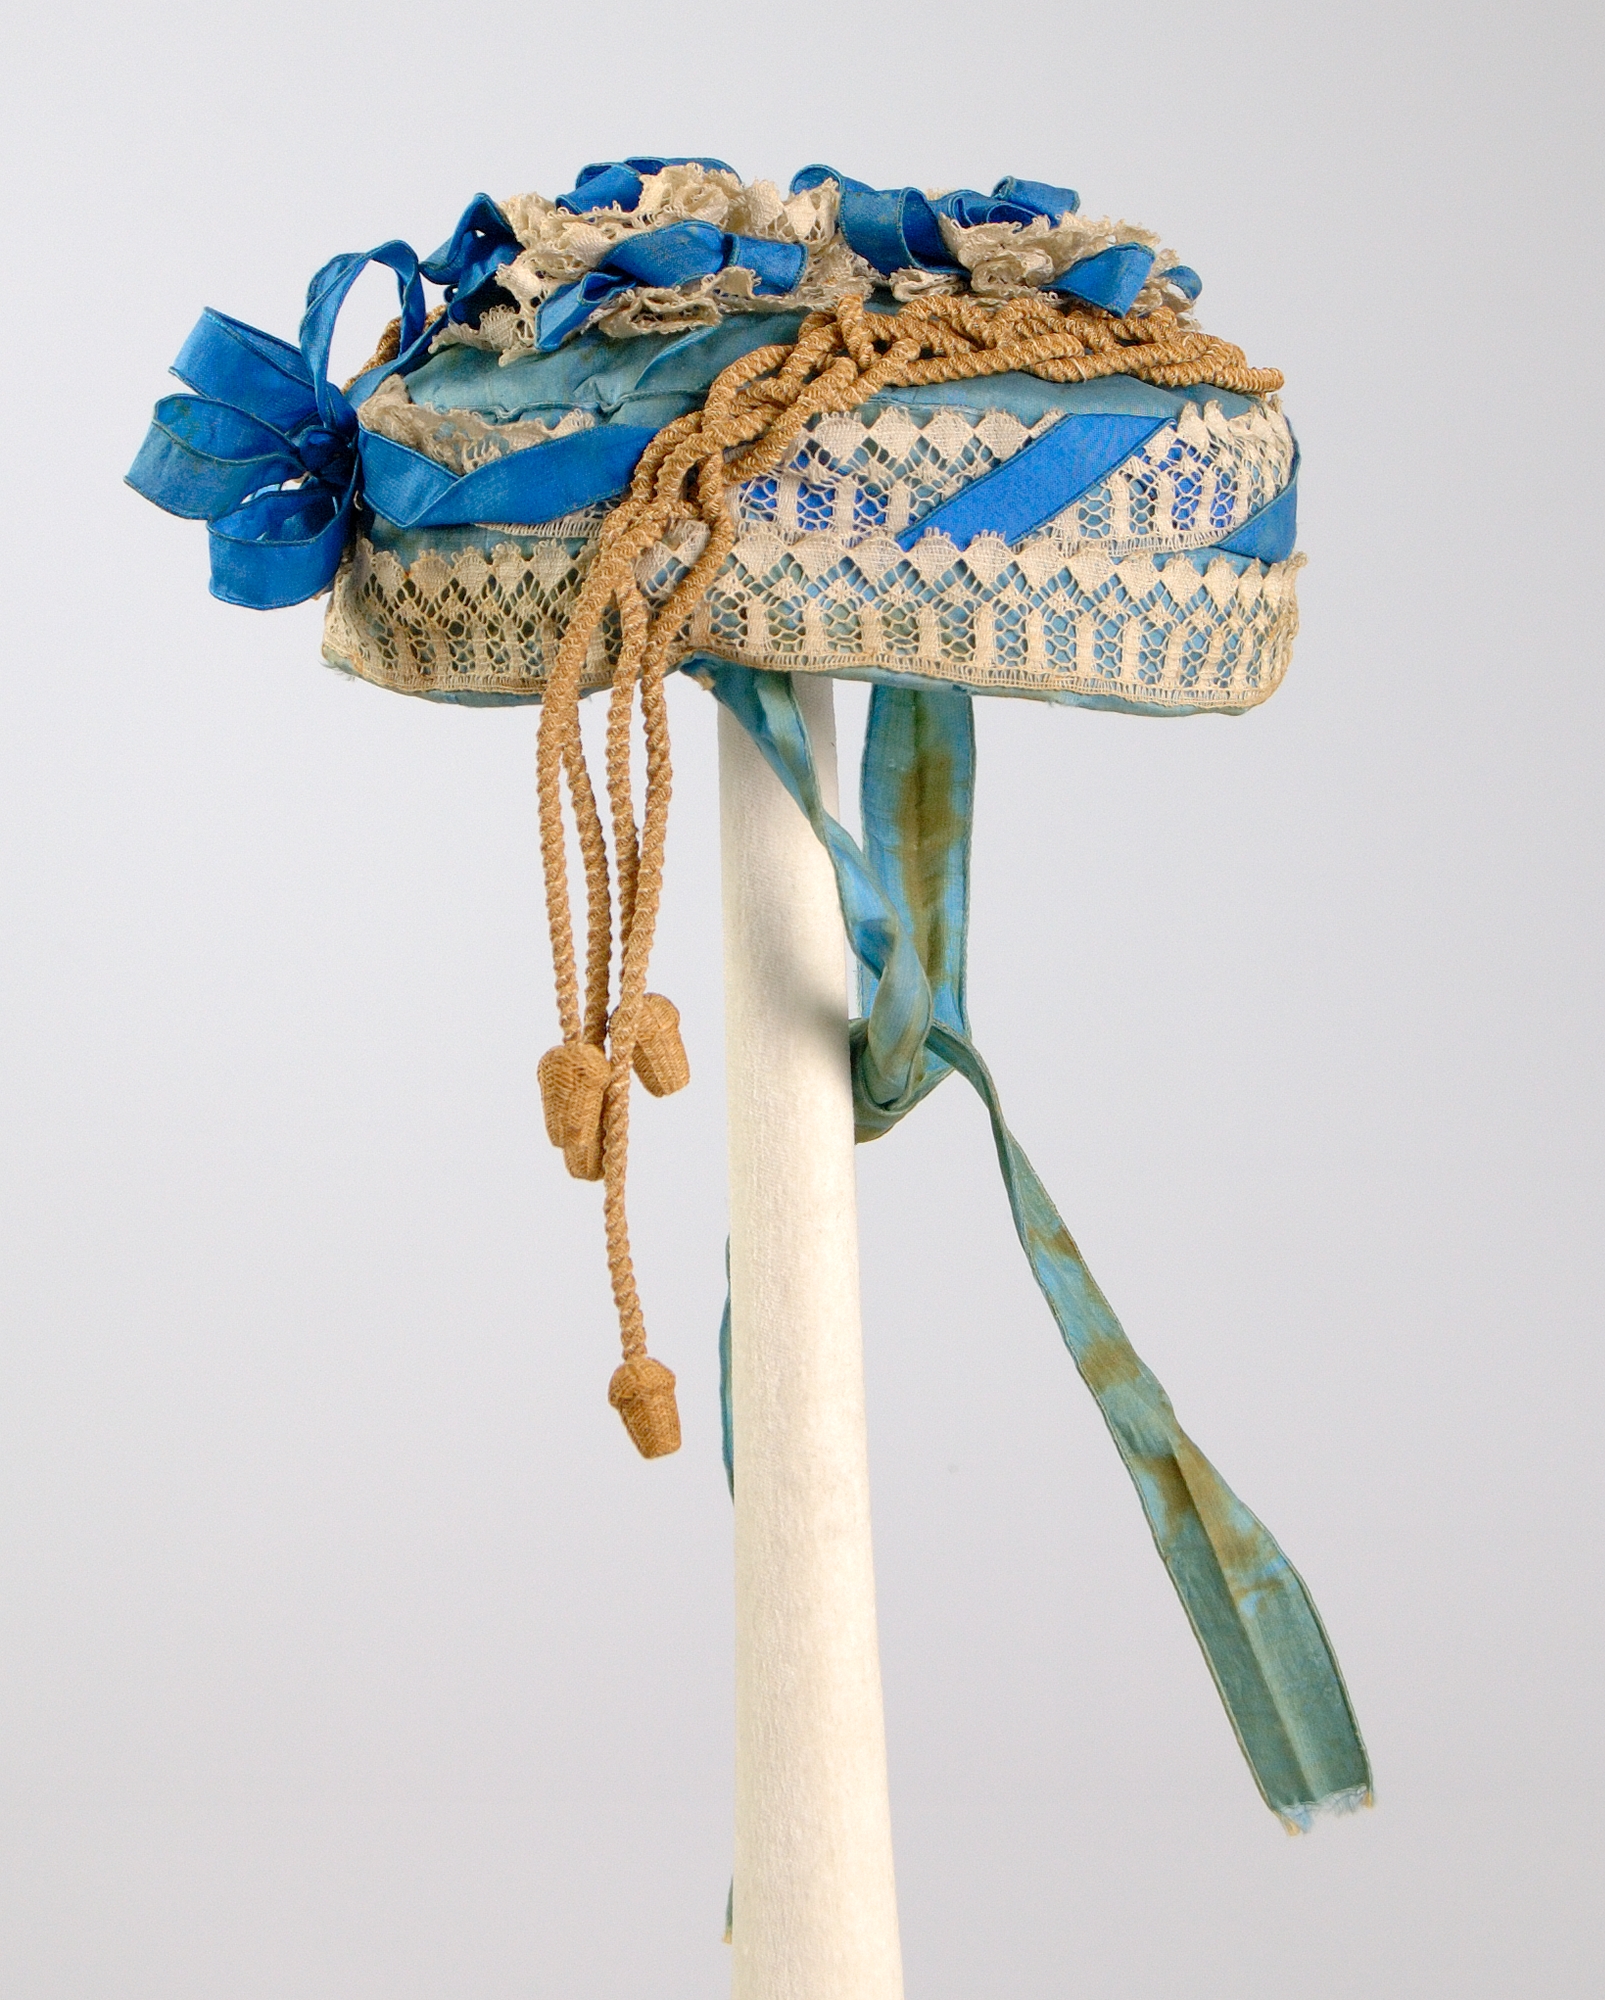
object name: bonnet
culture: american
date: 1865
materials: linen, silk, fiber